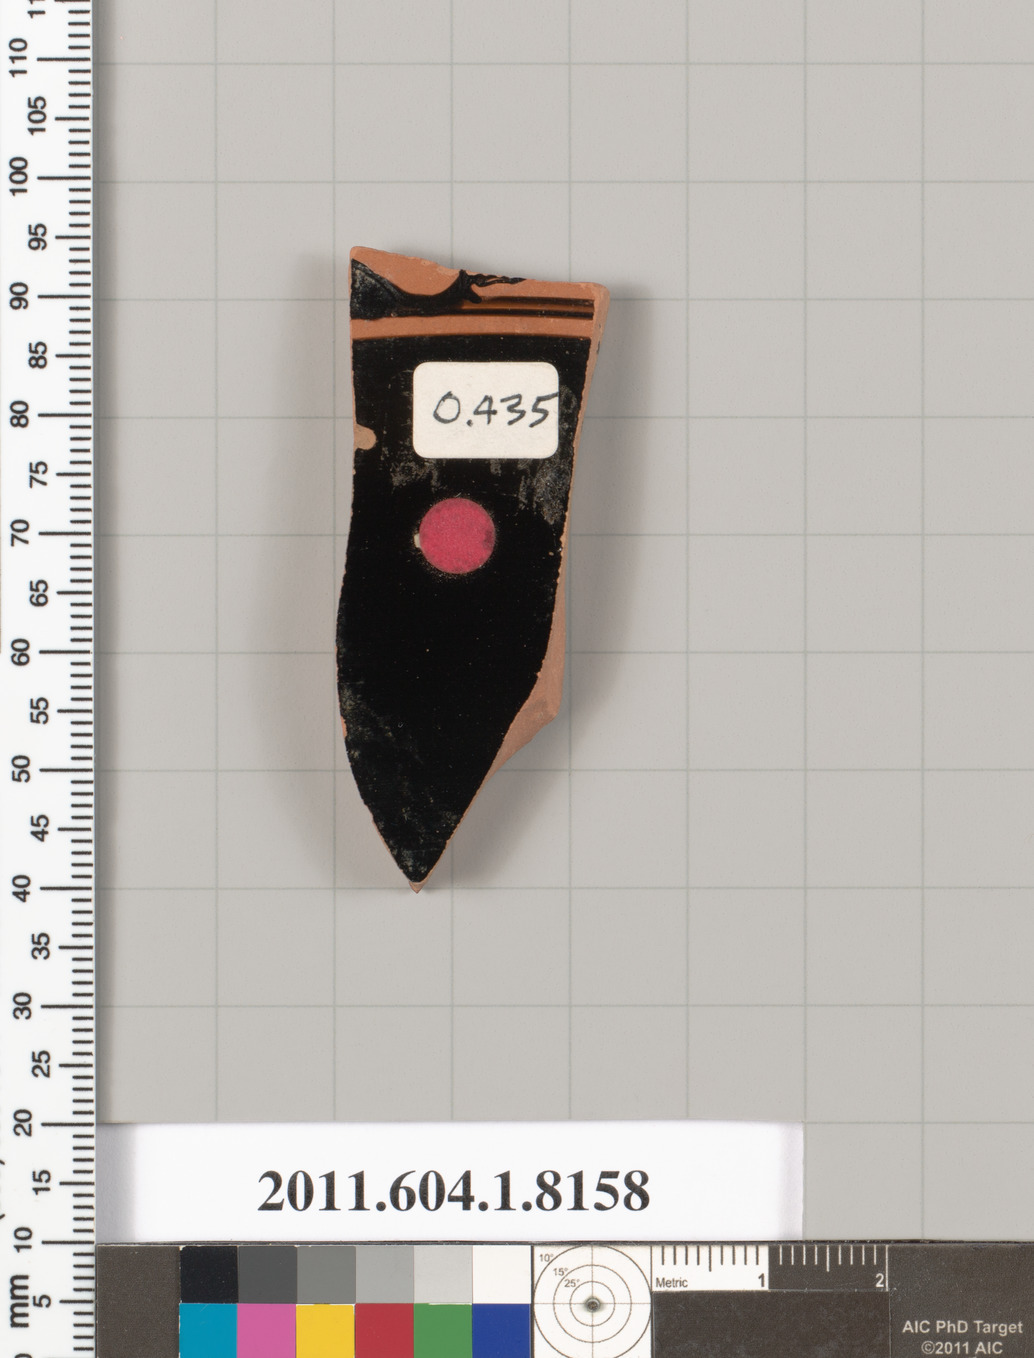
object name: kylix fragment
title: Terracotta fragment of a kylix (drinking cup)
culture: greek, attic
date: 520-510 BCE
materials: terracotta